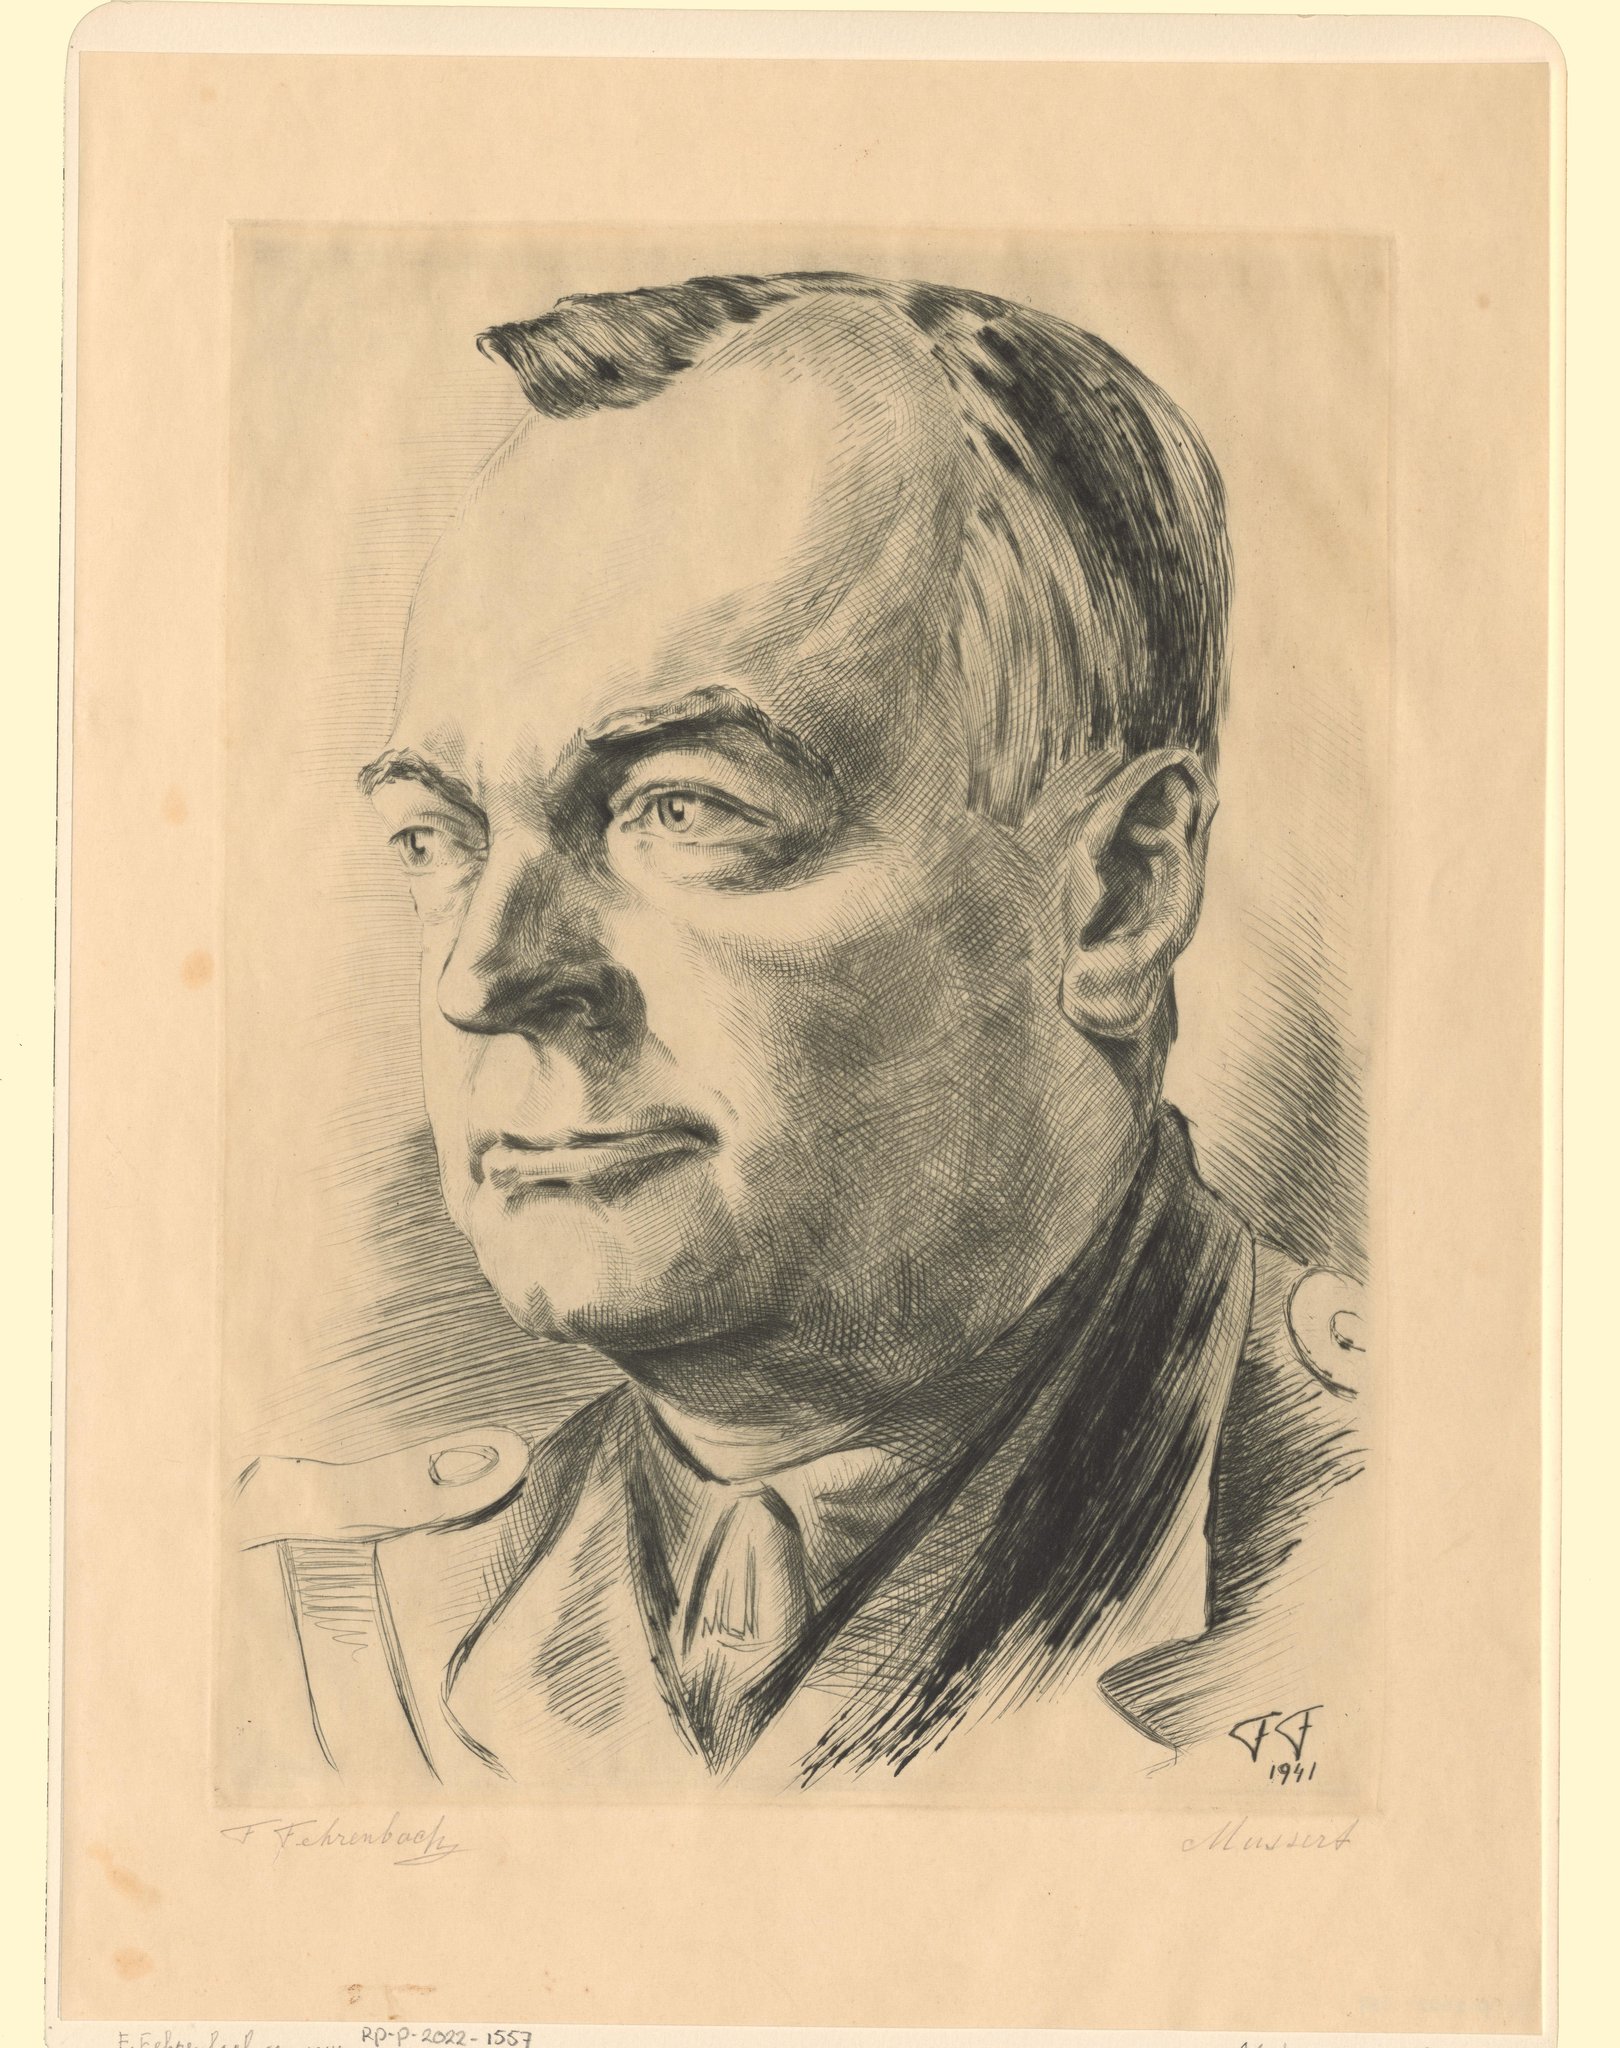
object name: print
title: Portret van Anton Mussert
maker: franciscus fehrenbach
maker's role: designer, draughtsman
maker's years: 1919-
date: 1941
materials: paper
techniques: engraving, retroussage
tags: the hague, politician, anton adriaan mussert, historical persons, netherlands